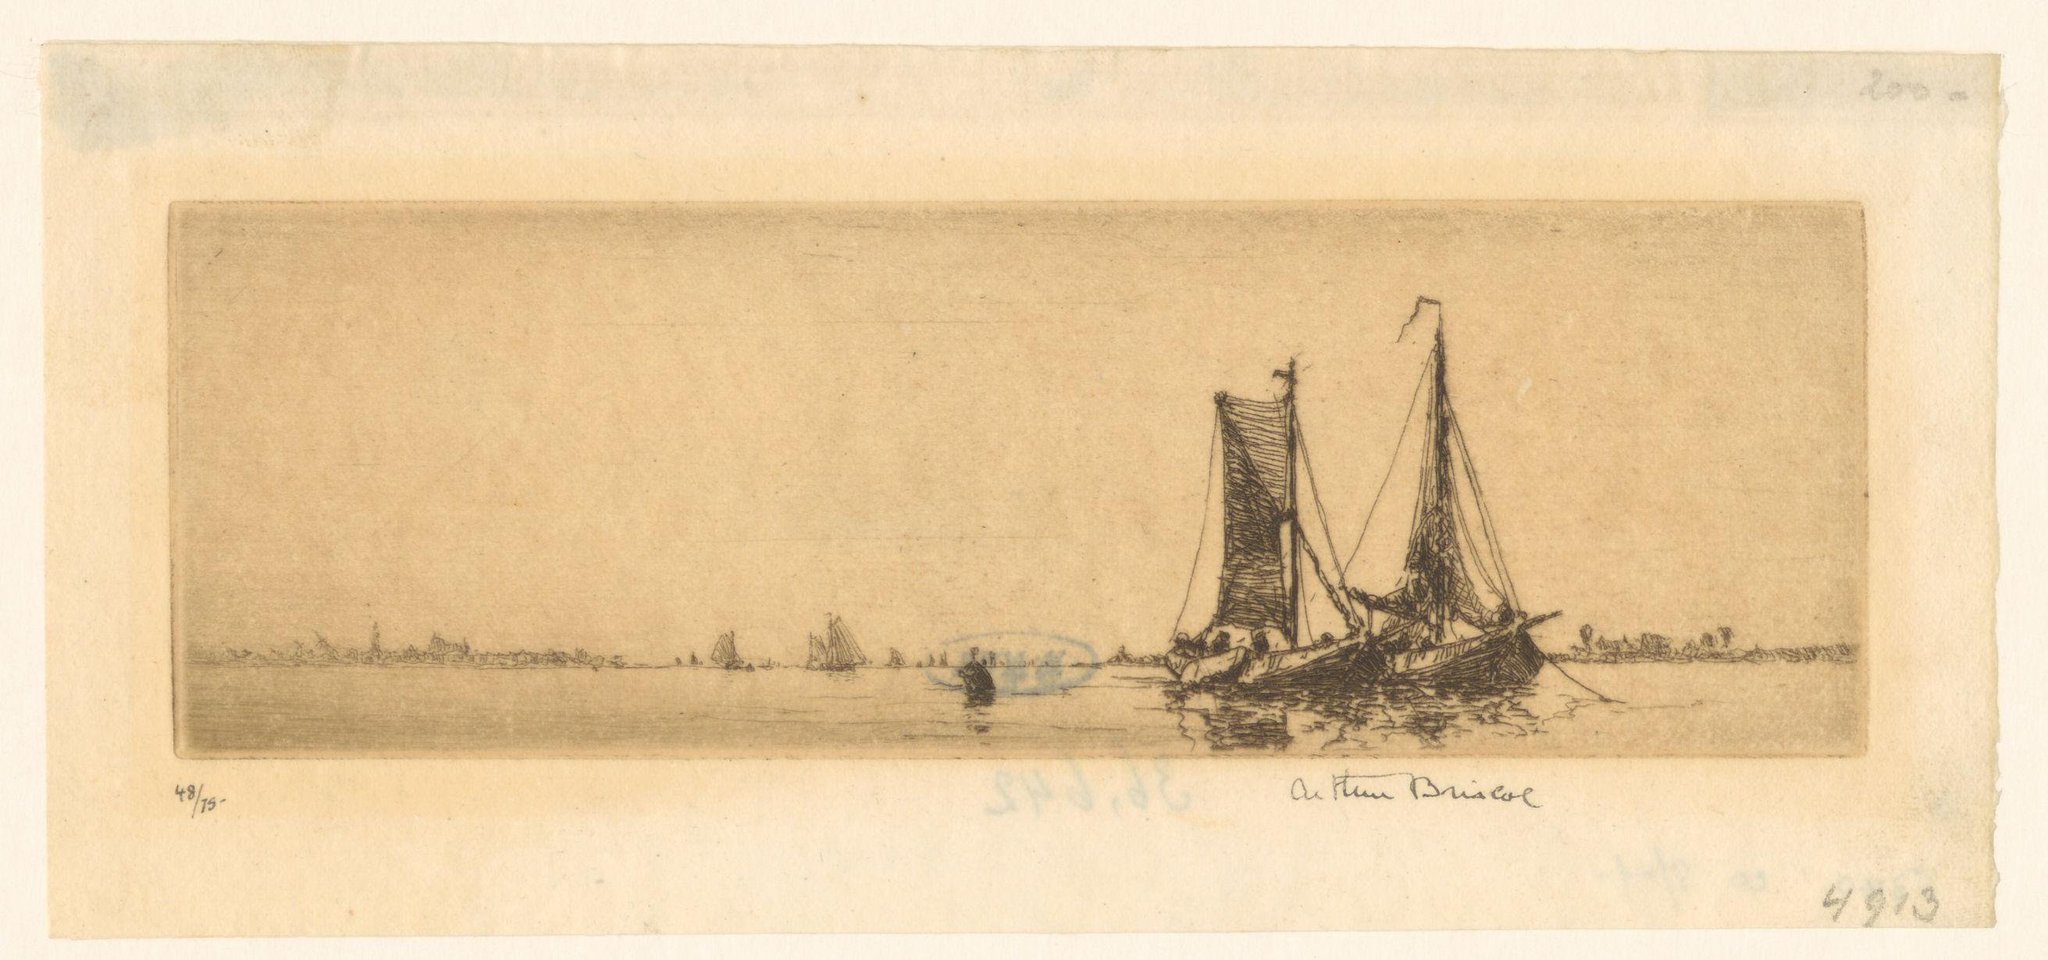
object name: print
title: Zaand Creek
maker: arthur john trevor briscoe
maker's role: print maker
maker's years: 1873-1943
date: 1924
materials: paper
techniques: drypoint, etching, intaglio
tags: sailing-ship, sailing-boat, river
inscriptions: collector's mark: Lugt 2228